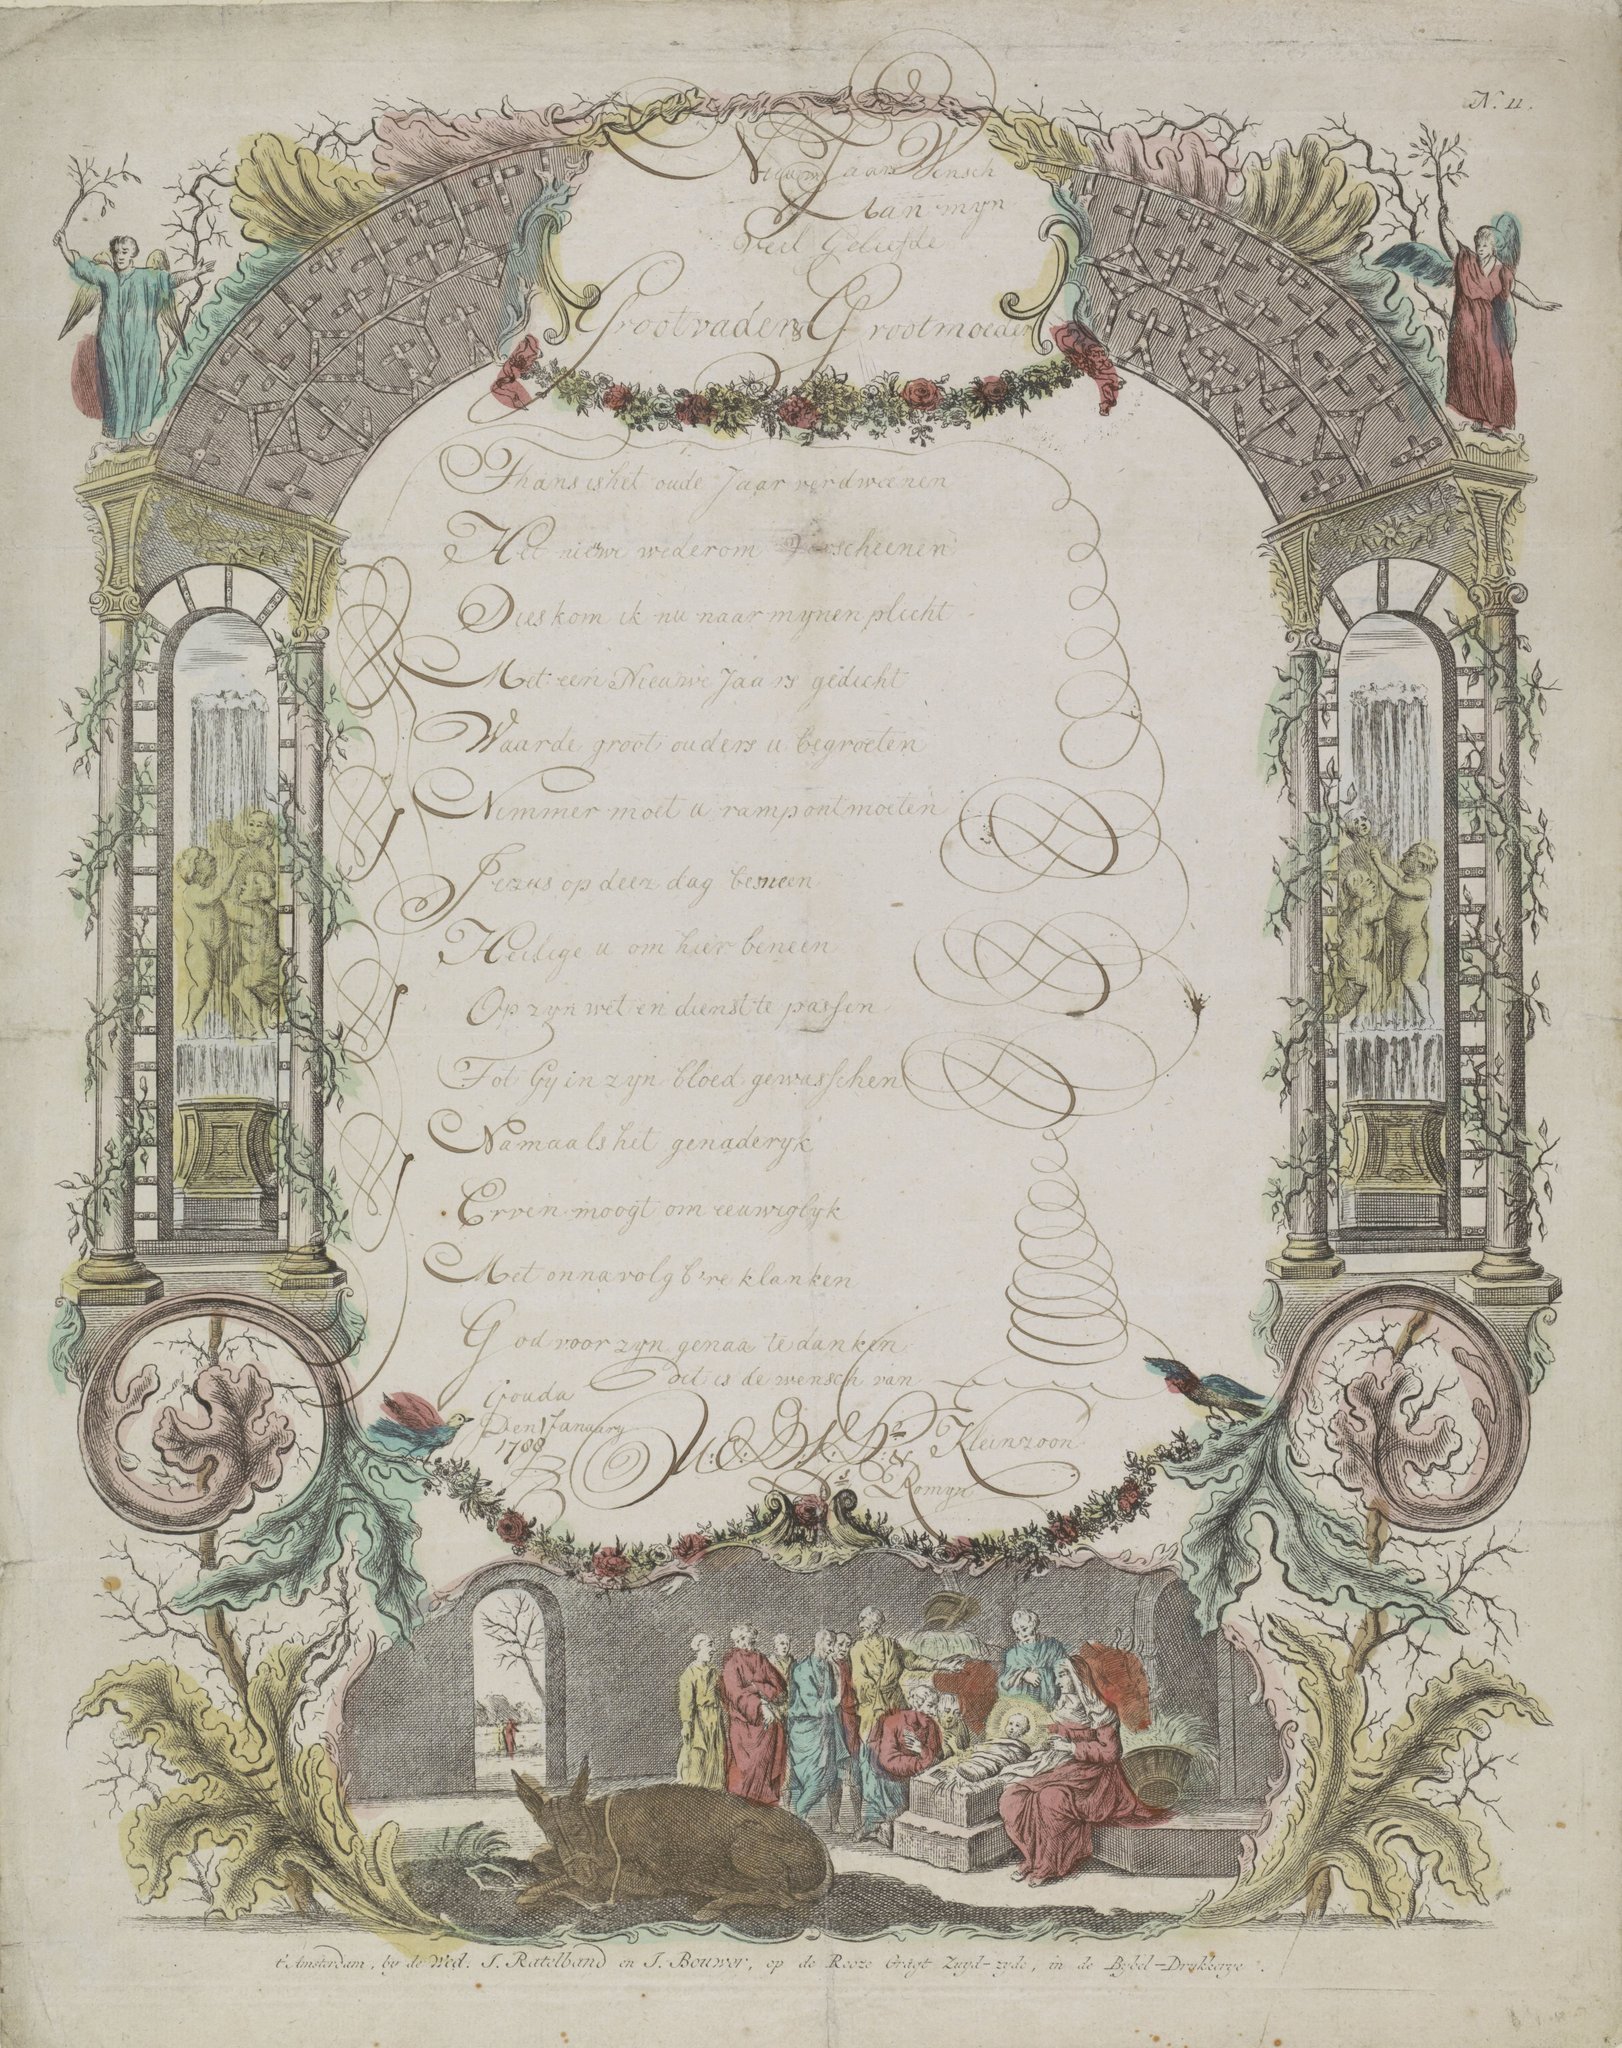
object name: wensbrief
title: Wensbrief met de aanbidding door de herders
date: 1767-1779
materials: ink, paper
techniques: calligraphy, colour, etching, pen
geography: amsterdam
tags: adoration of the christ-child by the shepherds; mary and joseph present, ass, donkey, cupids: 'amores', 'amoretti', 'putti', angels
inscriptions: collector's mark: Lugt 2760, inscription: ‘Nieuw jaar wensch / Aan myn / Veel geliefde / Grootvader en grootmoeder / Thans is het oude jaar verdwenen ...’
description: Wensbrief met beschreven cartouche binnen een decoratief kader met voorstellingen van de aanbidding door de herders, een ezel, engelen en putti. Handgeschreven bericht in kalligrafie (Nieuwjaarswens) door A. Romijn aan zijn grootvader en grootmoeder. Genummerd rechtsboven: N. 11.